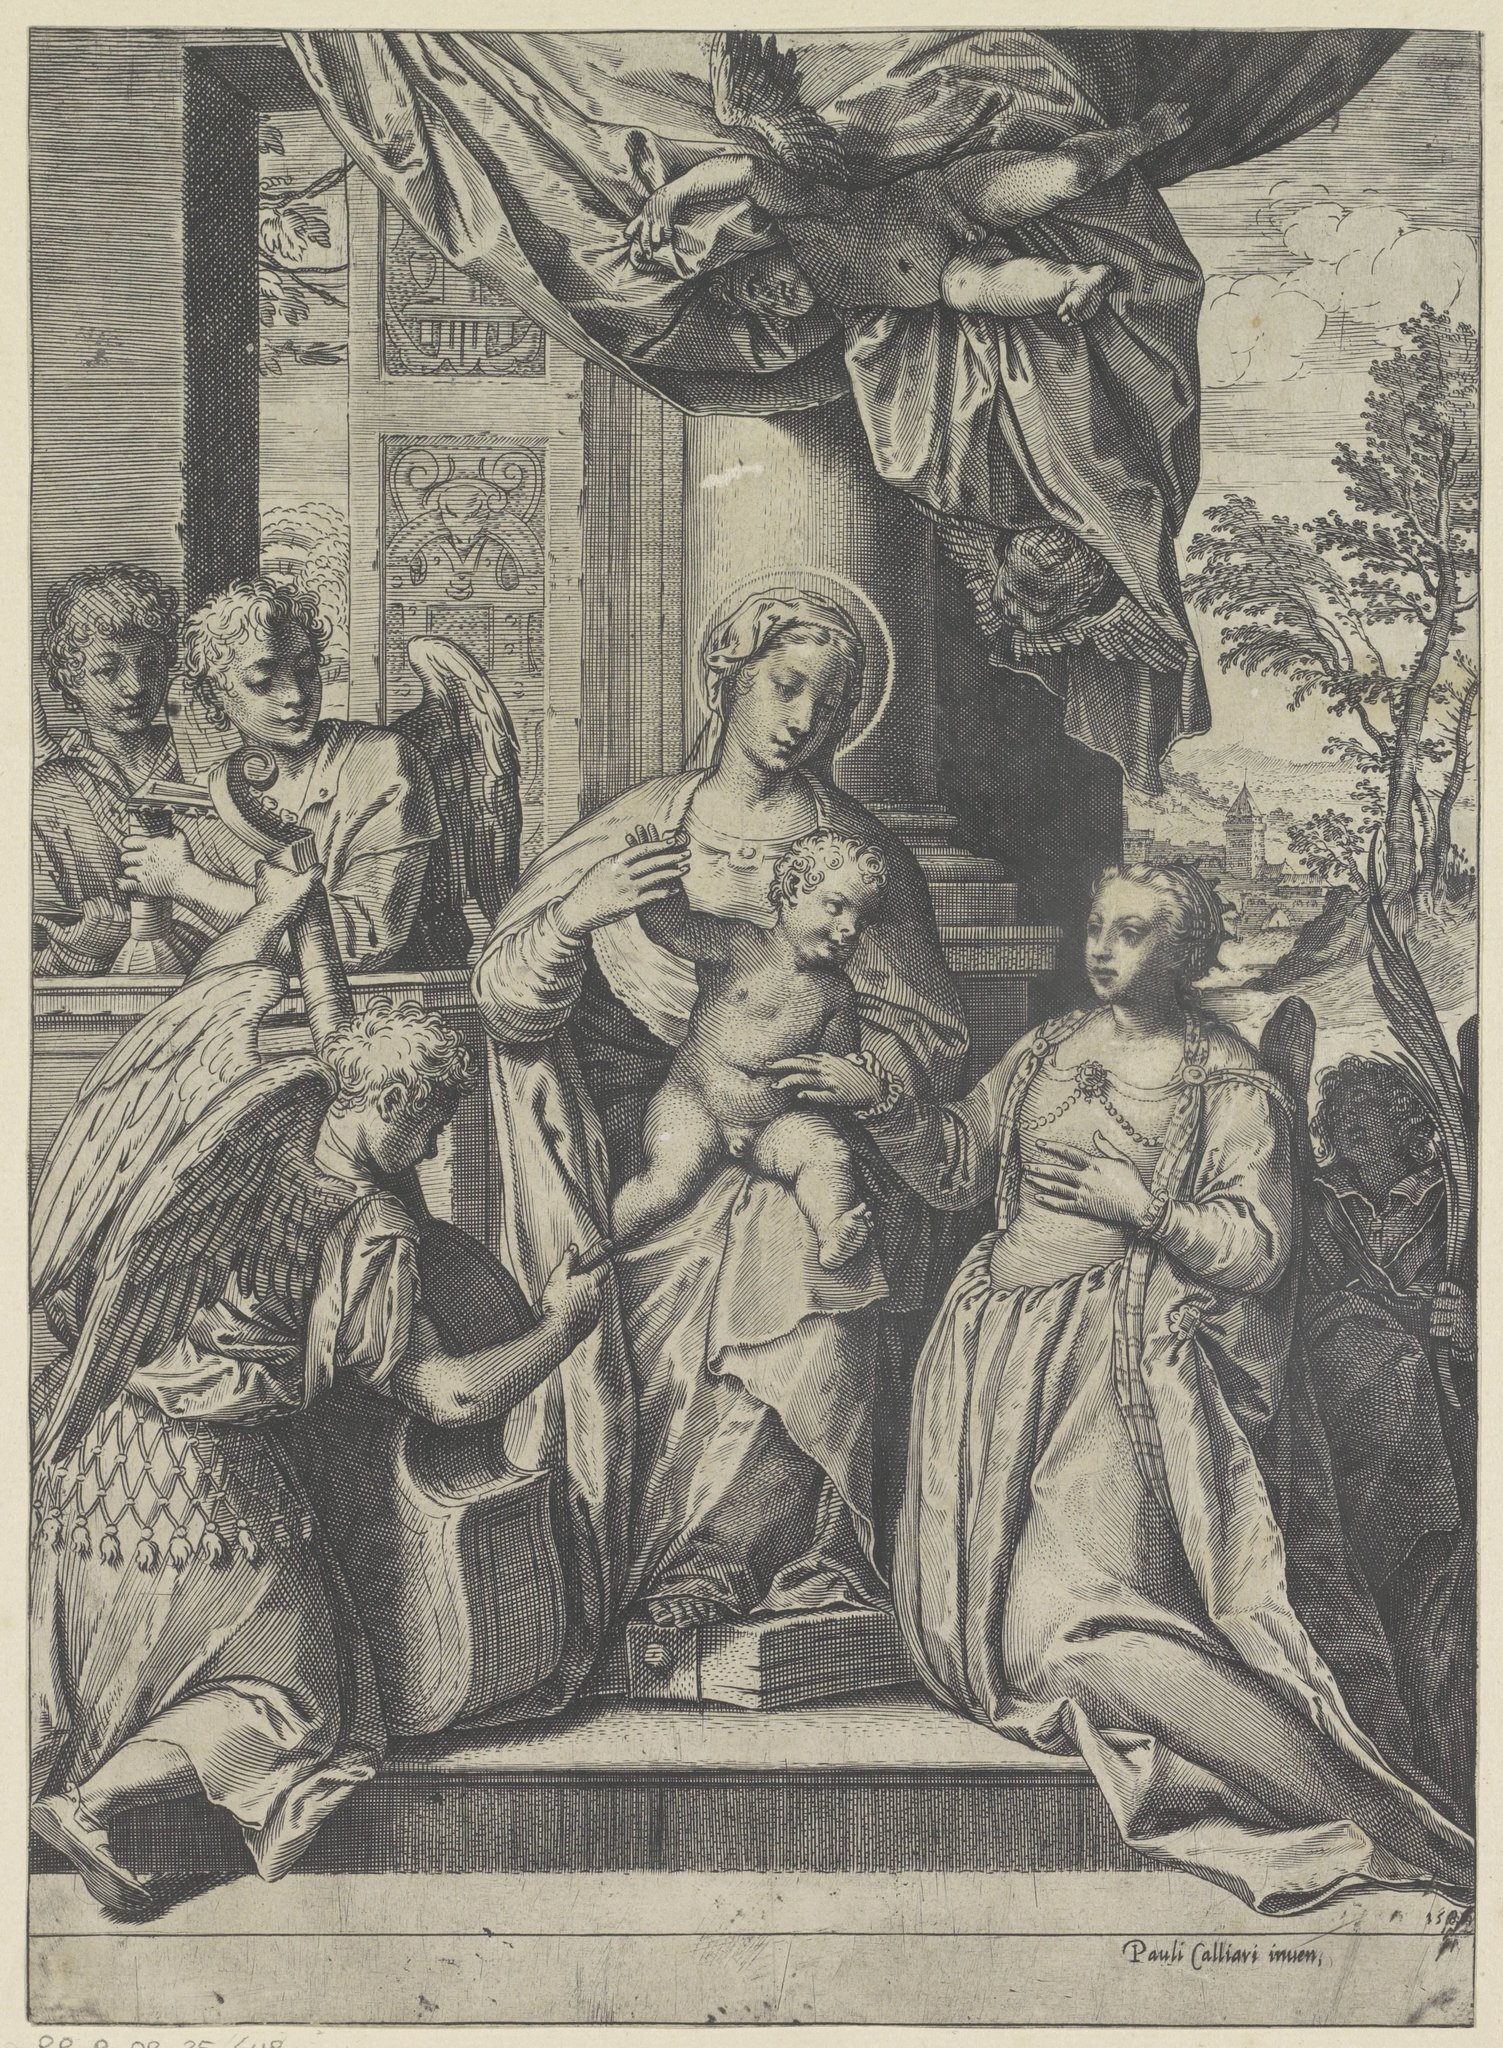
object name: print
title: Mystieke huwelijk van de heilige Catharina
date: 1585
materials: paper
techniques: engraving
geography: italy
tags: the mystic marriage of st. catherine of alexandria with the infant christ: the christ-child puts a ring on her finger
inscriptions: collector's mark: Lugt 240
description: Maria zit met het Christuskind op schoot. Christus staat op het punt een ring aan de vinger van de heilige Catharina van Alexandrië te schuiven. Links drie musicerende engelen. Rechts een engel met een palmtak.